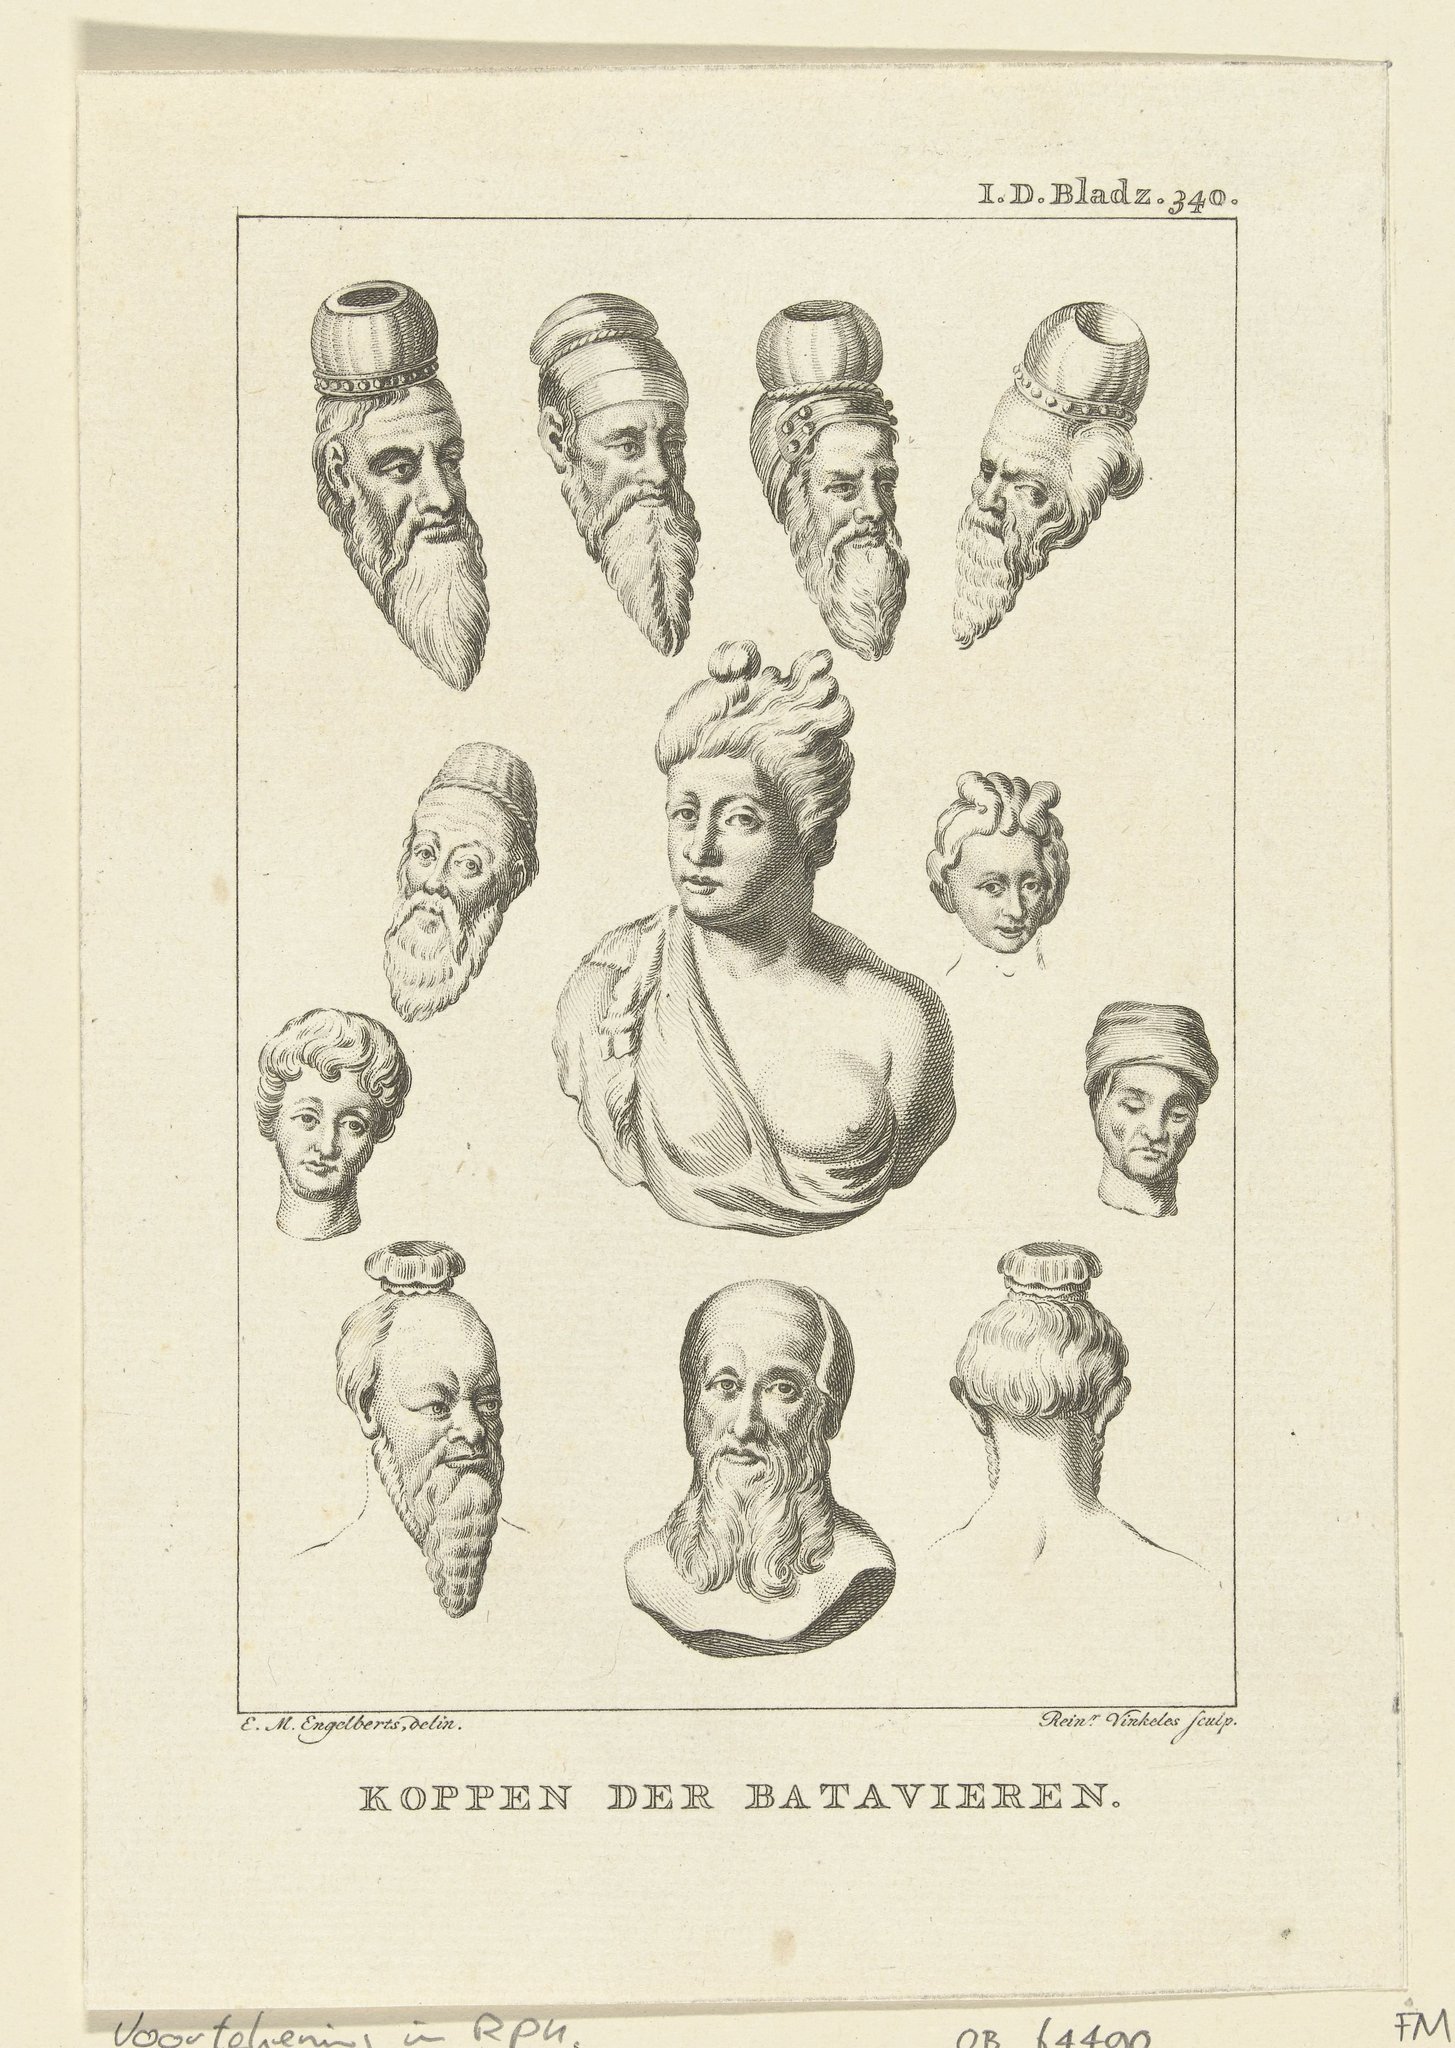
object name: historical object representation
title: Koppen der Batavieren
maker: reinier vinkeles (i)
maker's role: draughtsman, print maker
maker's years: 1741-1816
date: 1782-1784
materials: paper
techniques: etching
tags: extinct, 'historical' peoples (with name)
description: Illustratie uit: E.M. Engelberts, De aloude staat en geschiedenissen der Vereenigde Nederlanden, Johannes Allart, Amsterdam 1784-1799, dl. I, blz. 340. Staat met de letter.